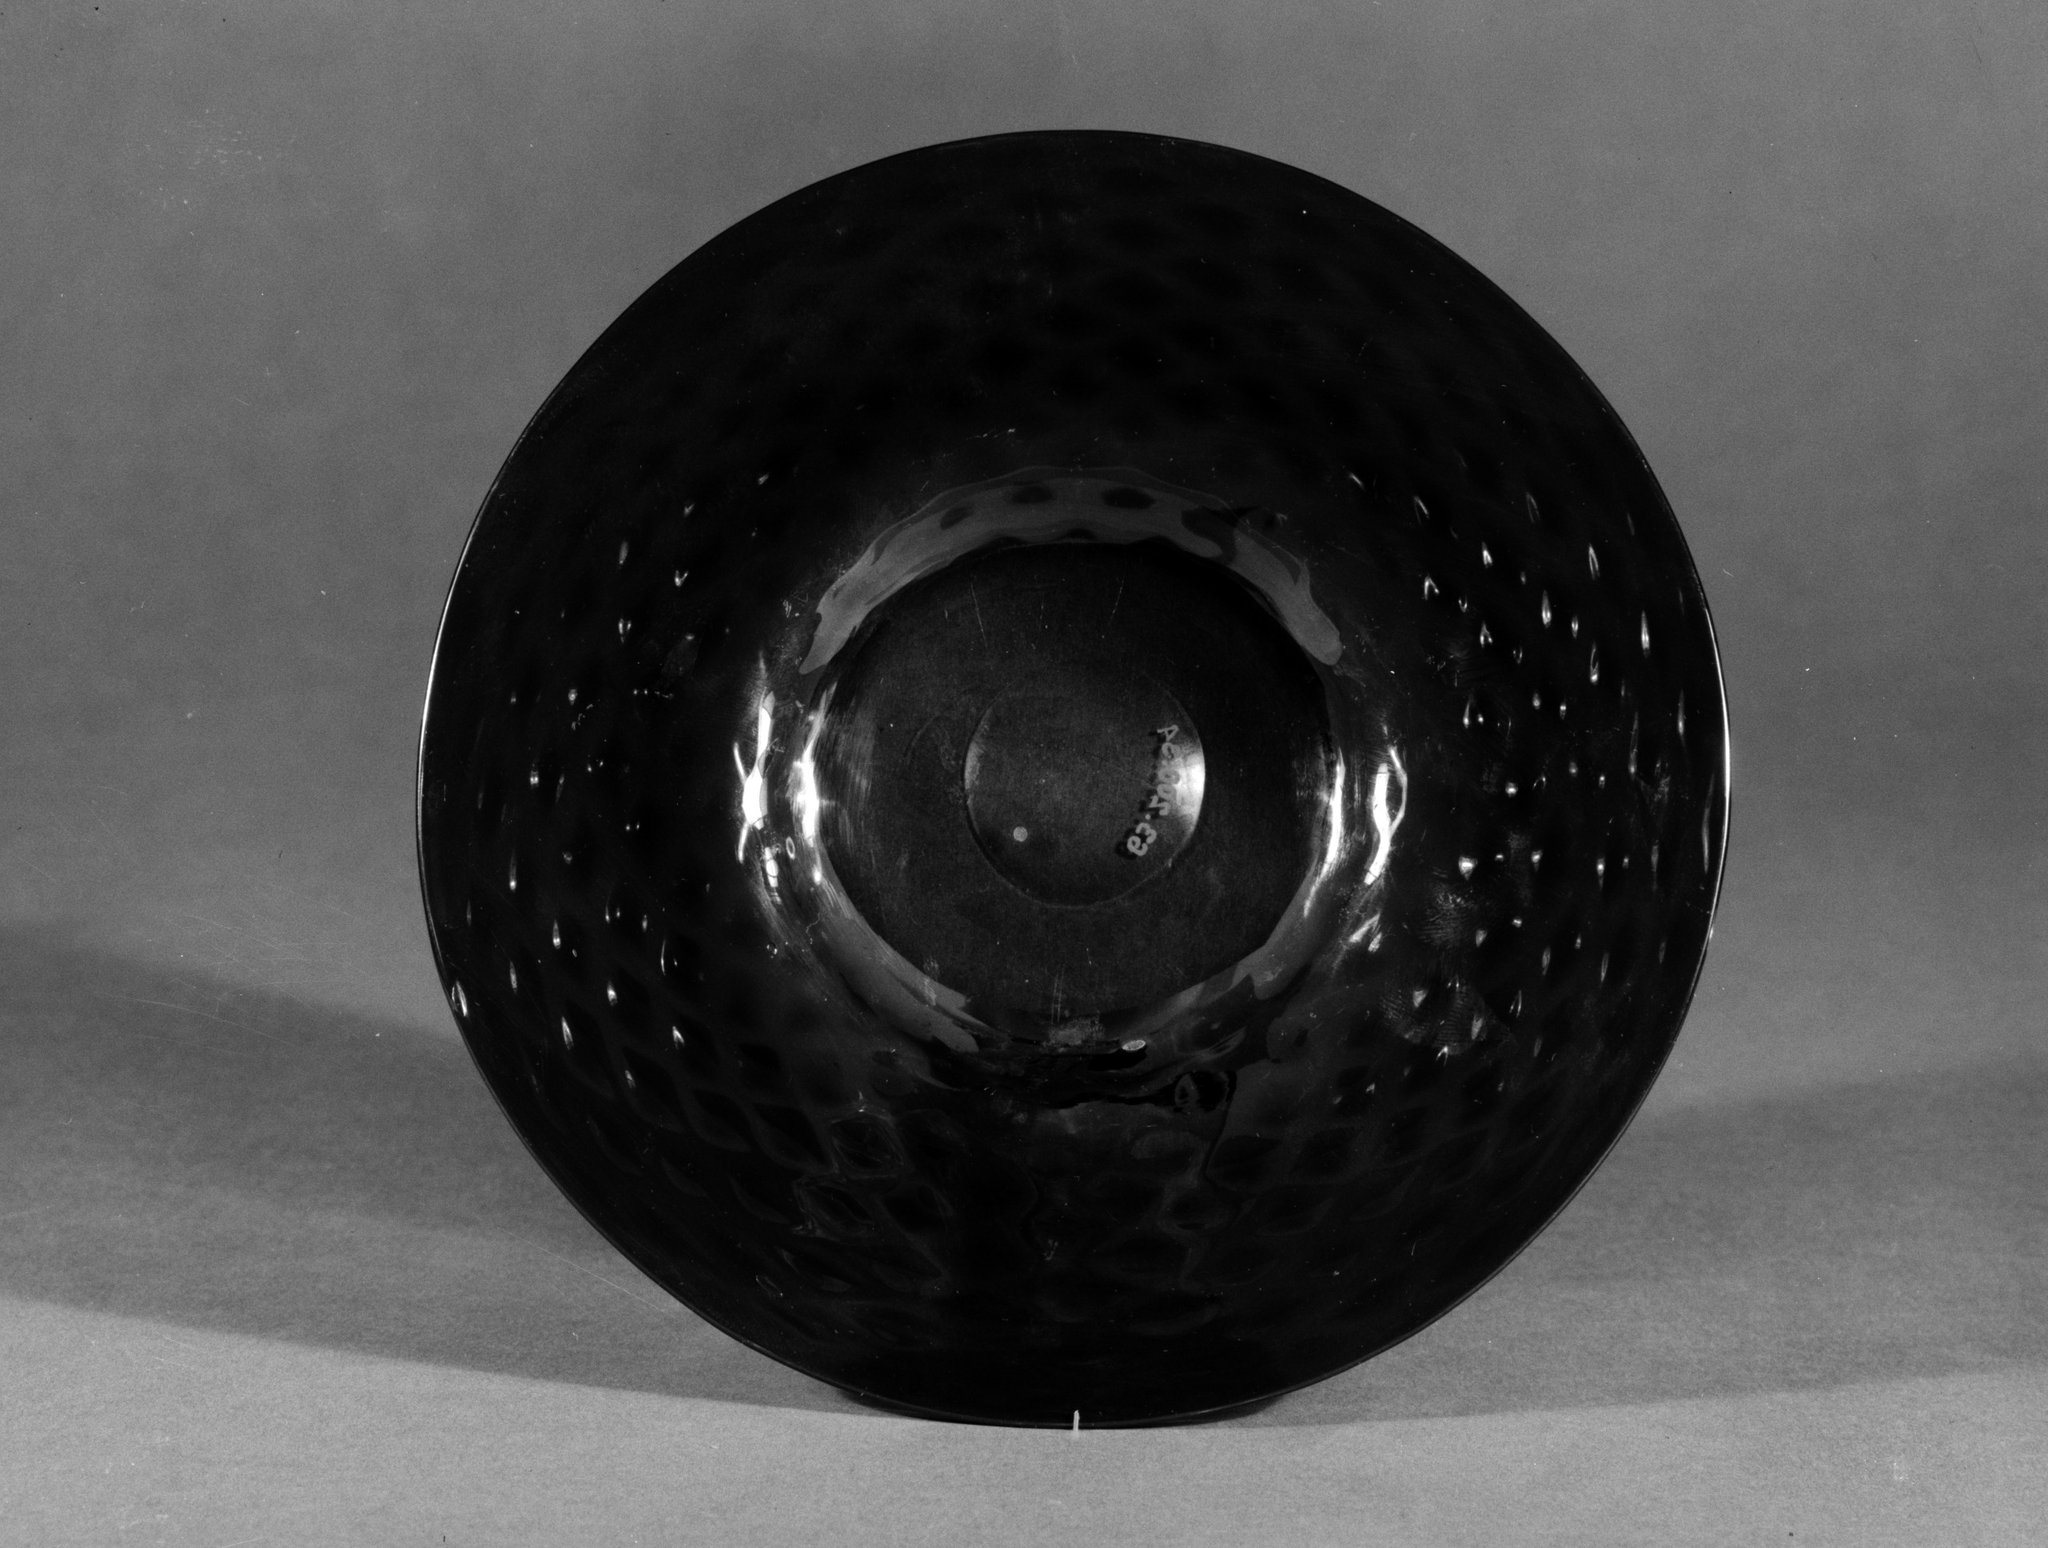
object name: plate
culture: american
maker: new england glass company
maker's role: maker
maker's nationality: american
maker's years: 1818-1888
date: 1886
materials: glass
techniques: glassblowing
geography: united states